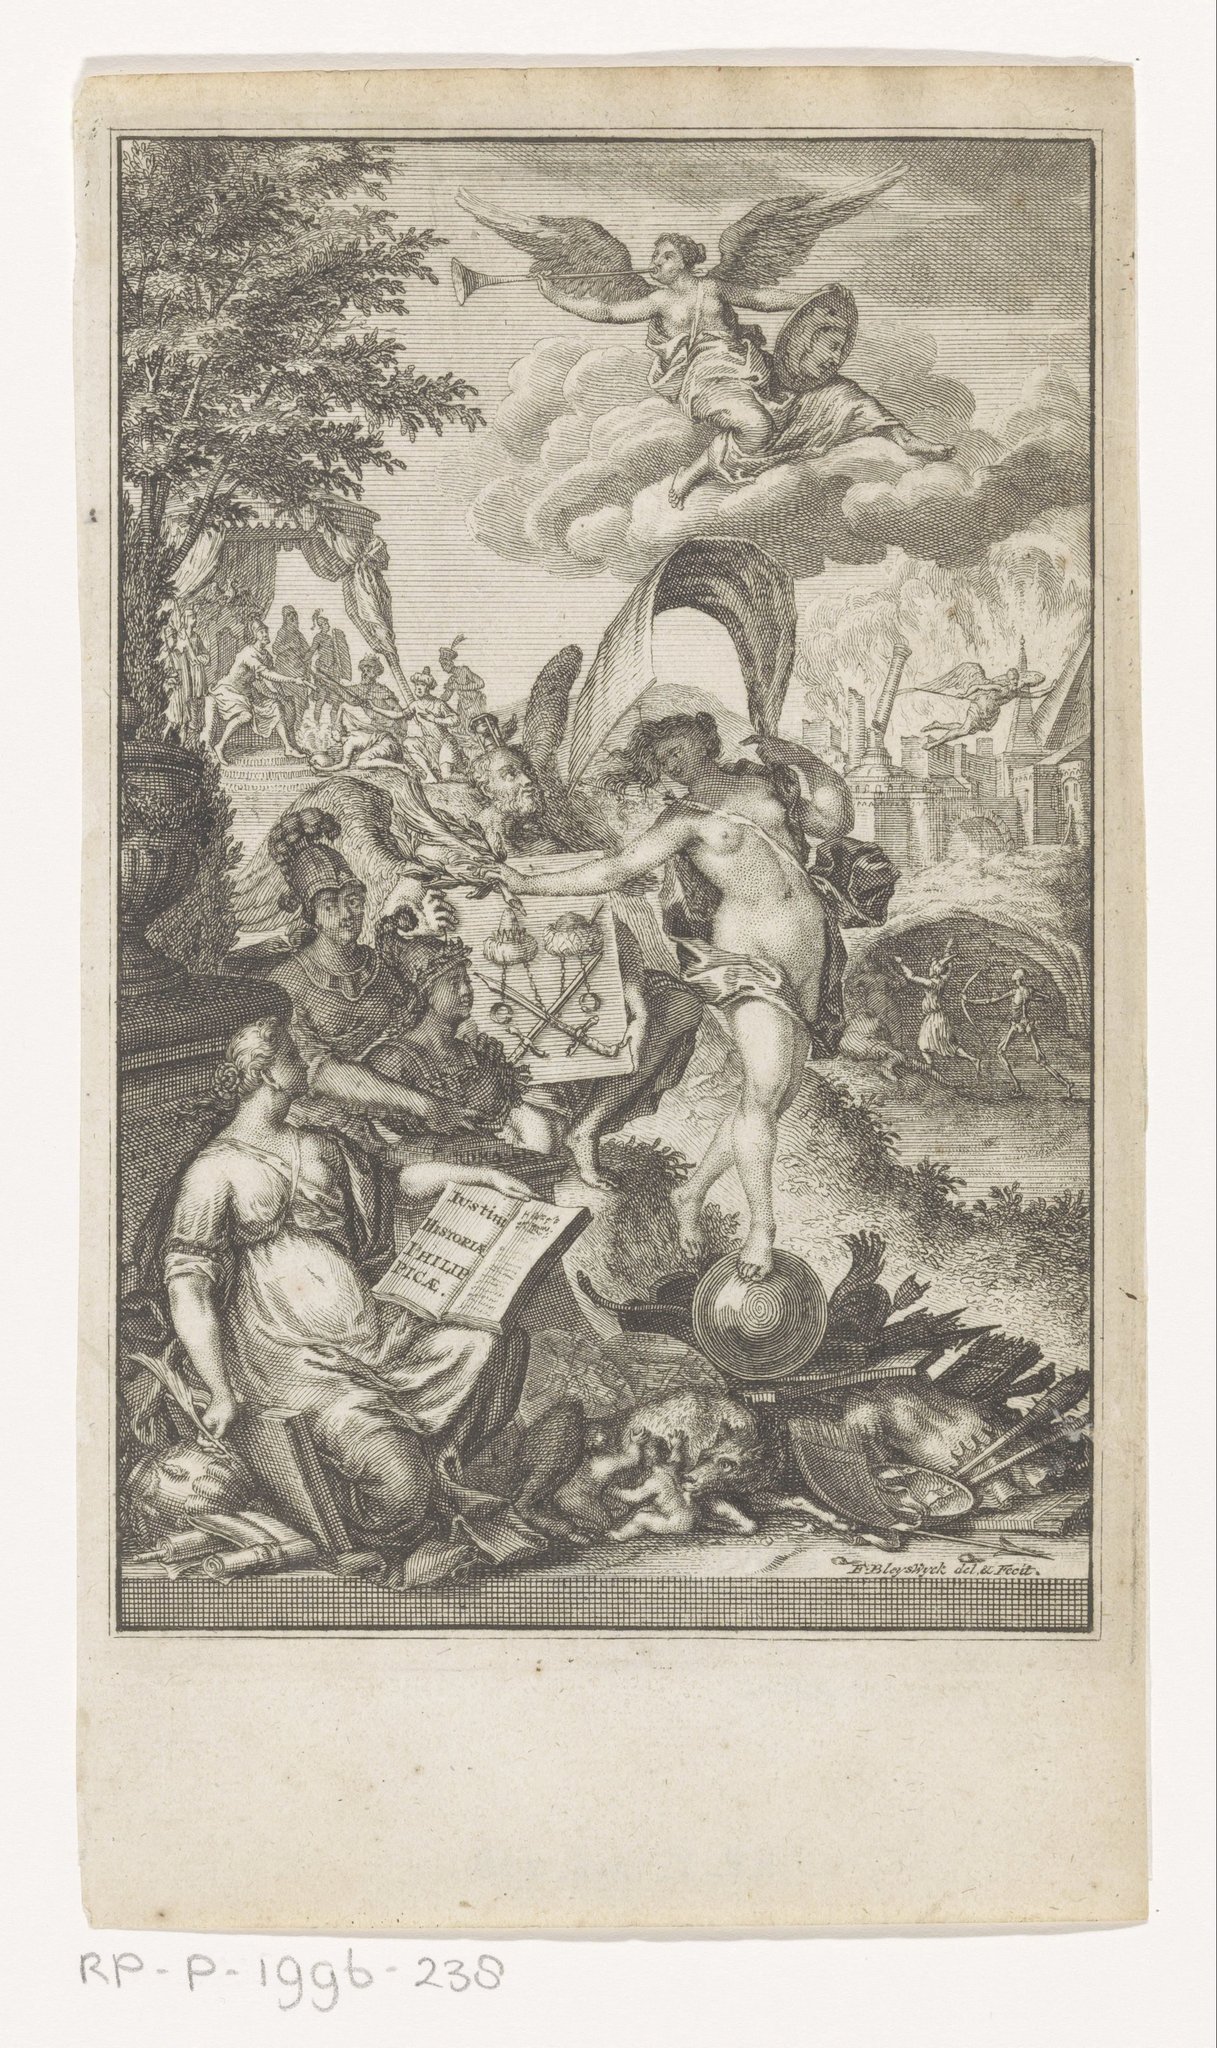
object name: titelblad, titelpagina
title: Allegorie op de overwinning op Macedonië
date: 1719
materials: paper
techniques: engraving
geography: leiden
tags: victory, luck, fortune, lot; 'fato', 'fortuna', 'fortuna aurea', 'fortuna buona', 'fortuna pacifica overo clemente', 'sorte' (ripa), 'historia'; 'historia' (ripa), rome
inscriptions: collector's mark: Lugt 2760, collector's mark: Lugt 2228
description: Op de voorgrond zit Geschiedenis met een open boek met titel. Achter haar staat Minerva met een buste van Roma. Rechts balanceert Fortuna op een globe, zij lauwert de buste. Vader Tijd met zandloper op het hoofd staat achter de drie vrouwen met een bord met tulbanden en zwaarden. In de lucht blaast Fama op een bazuin, in haar hand houdt zij een portretmedaillon. In de achtergrond rechts een brandende stad (mogelijk in de Macedonische monarchie), links zit een keizer onder een baldakijn.